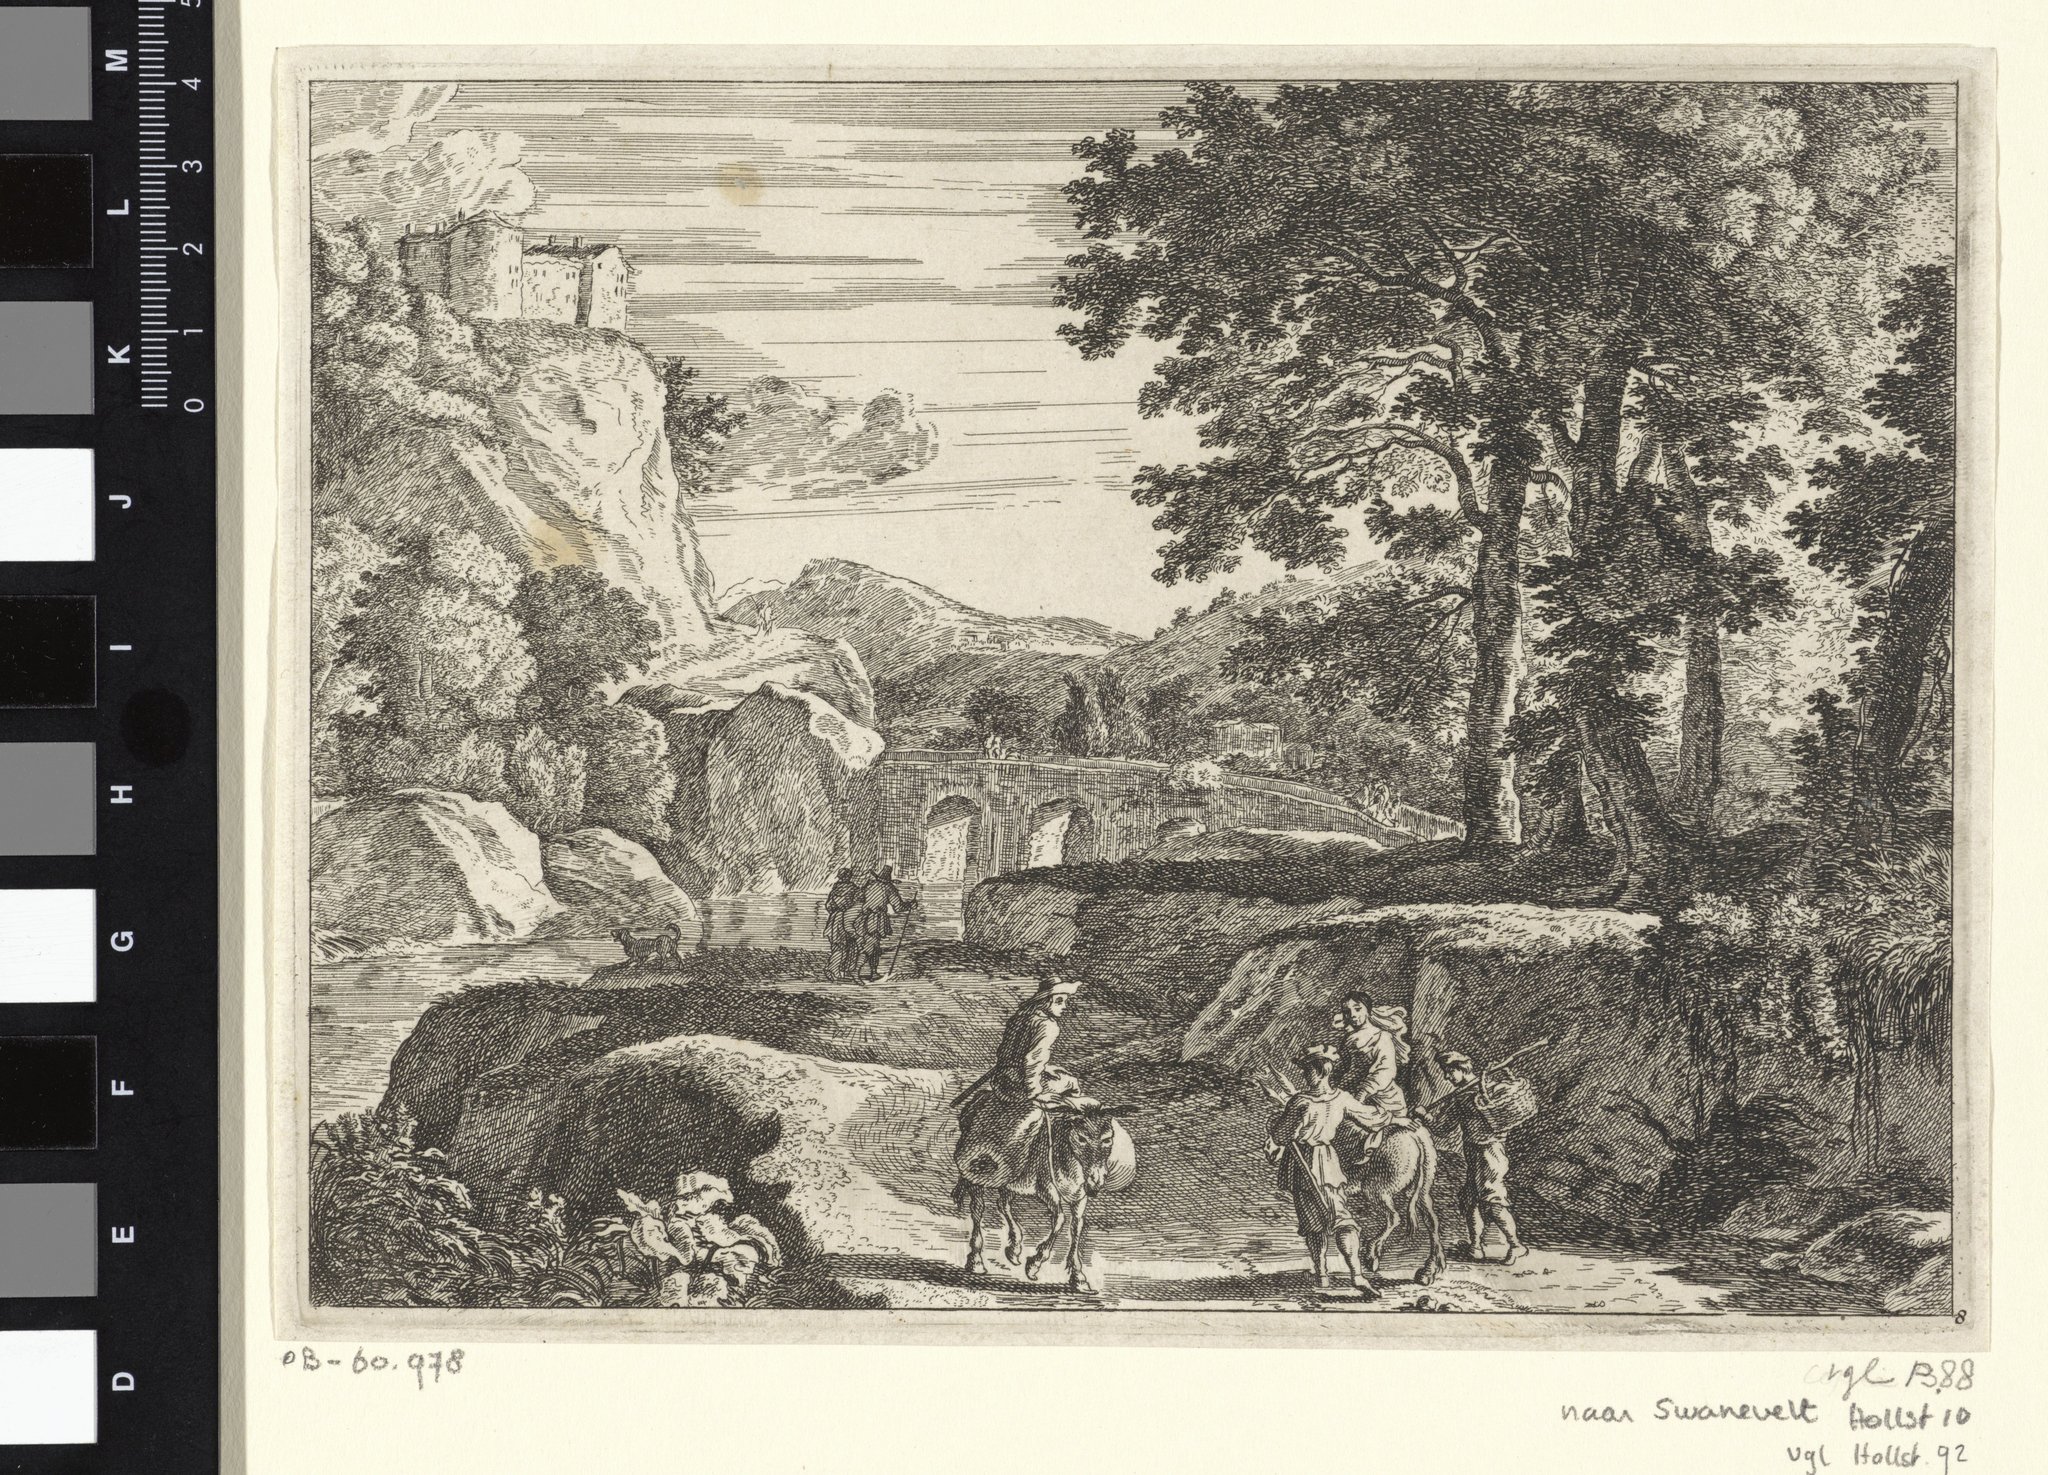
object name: print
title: Verscheyde aerdige lantschappen (...)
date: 1633-1679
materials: paper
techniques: etching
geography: amsterdam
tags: riding a horse, ass, or mule; rider, horseman, ass, donkey, river, bridge, 'en route', traveller under way, rocks, mountains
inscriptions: collector's mark: Lugt 240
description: Een man en een vrouw zitten ieder op een bepakte ezel. Ze worden begeleid door twee lopende figuren. Naast hen loopt een rivier, die door een stenen boogbrug wordt overspannen. In de verte ligt een gebouw op een hoge rots.